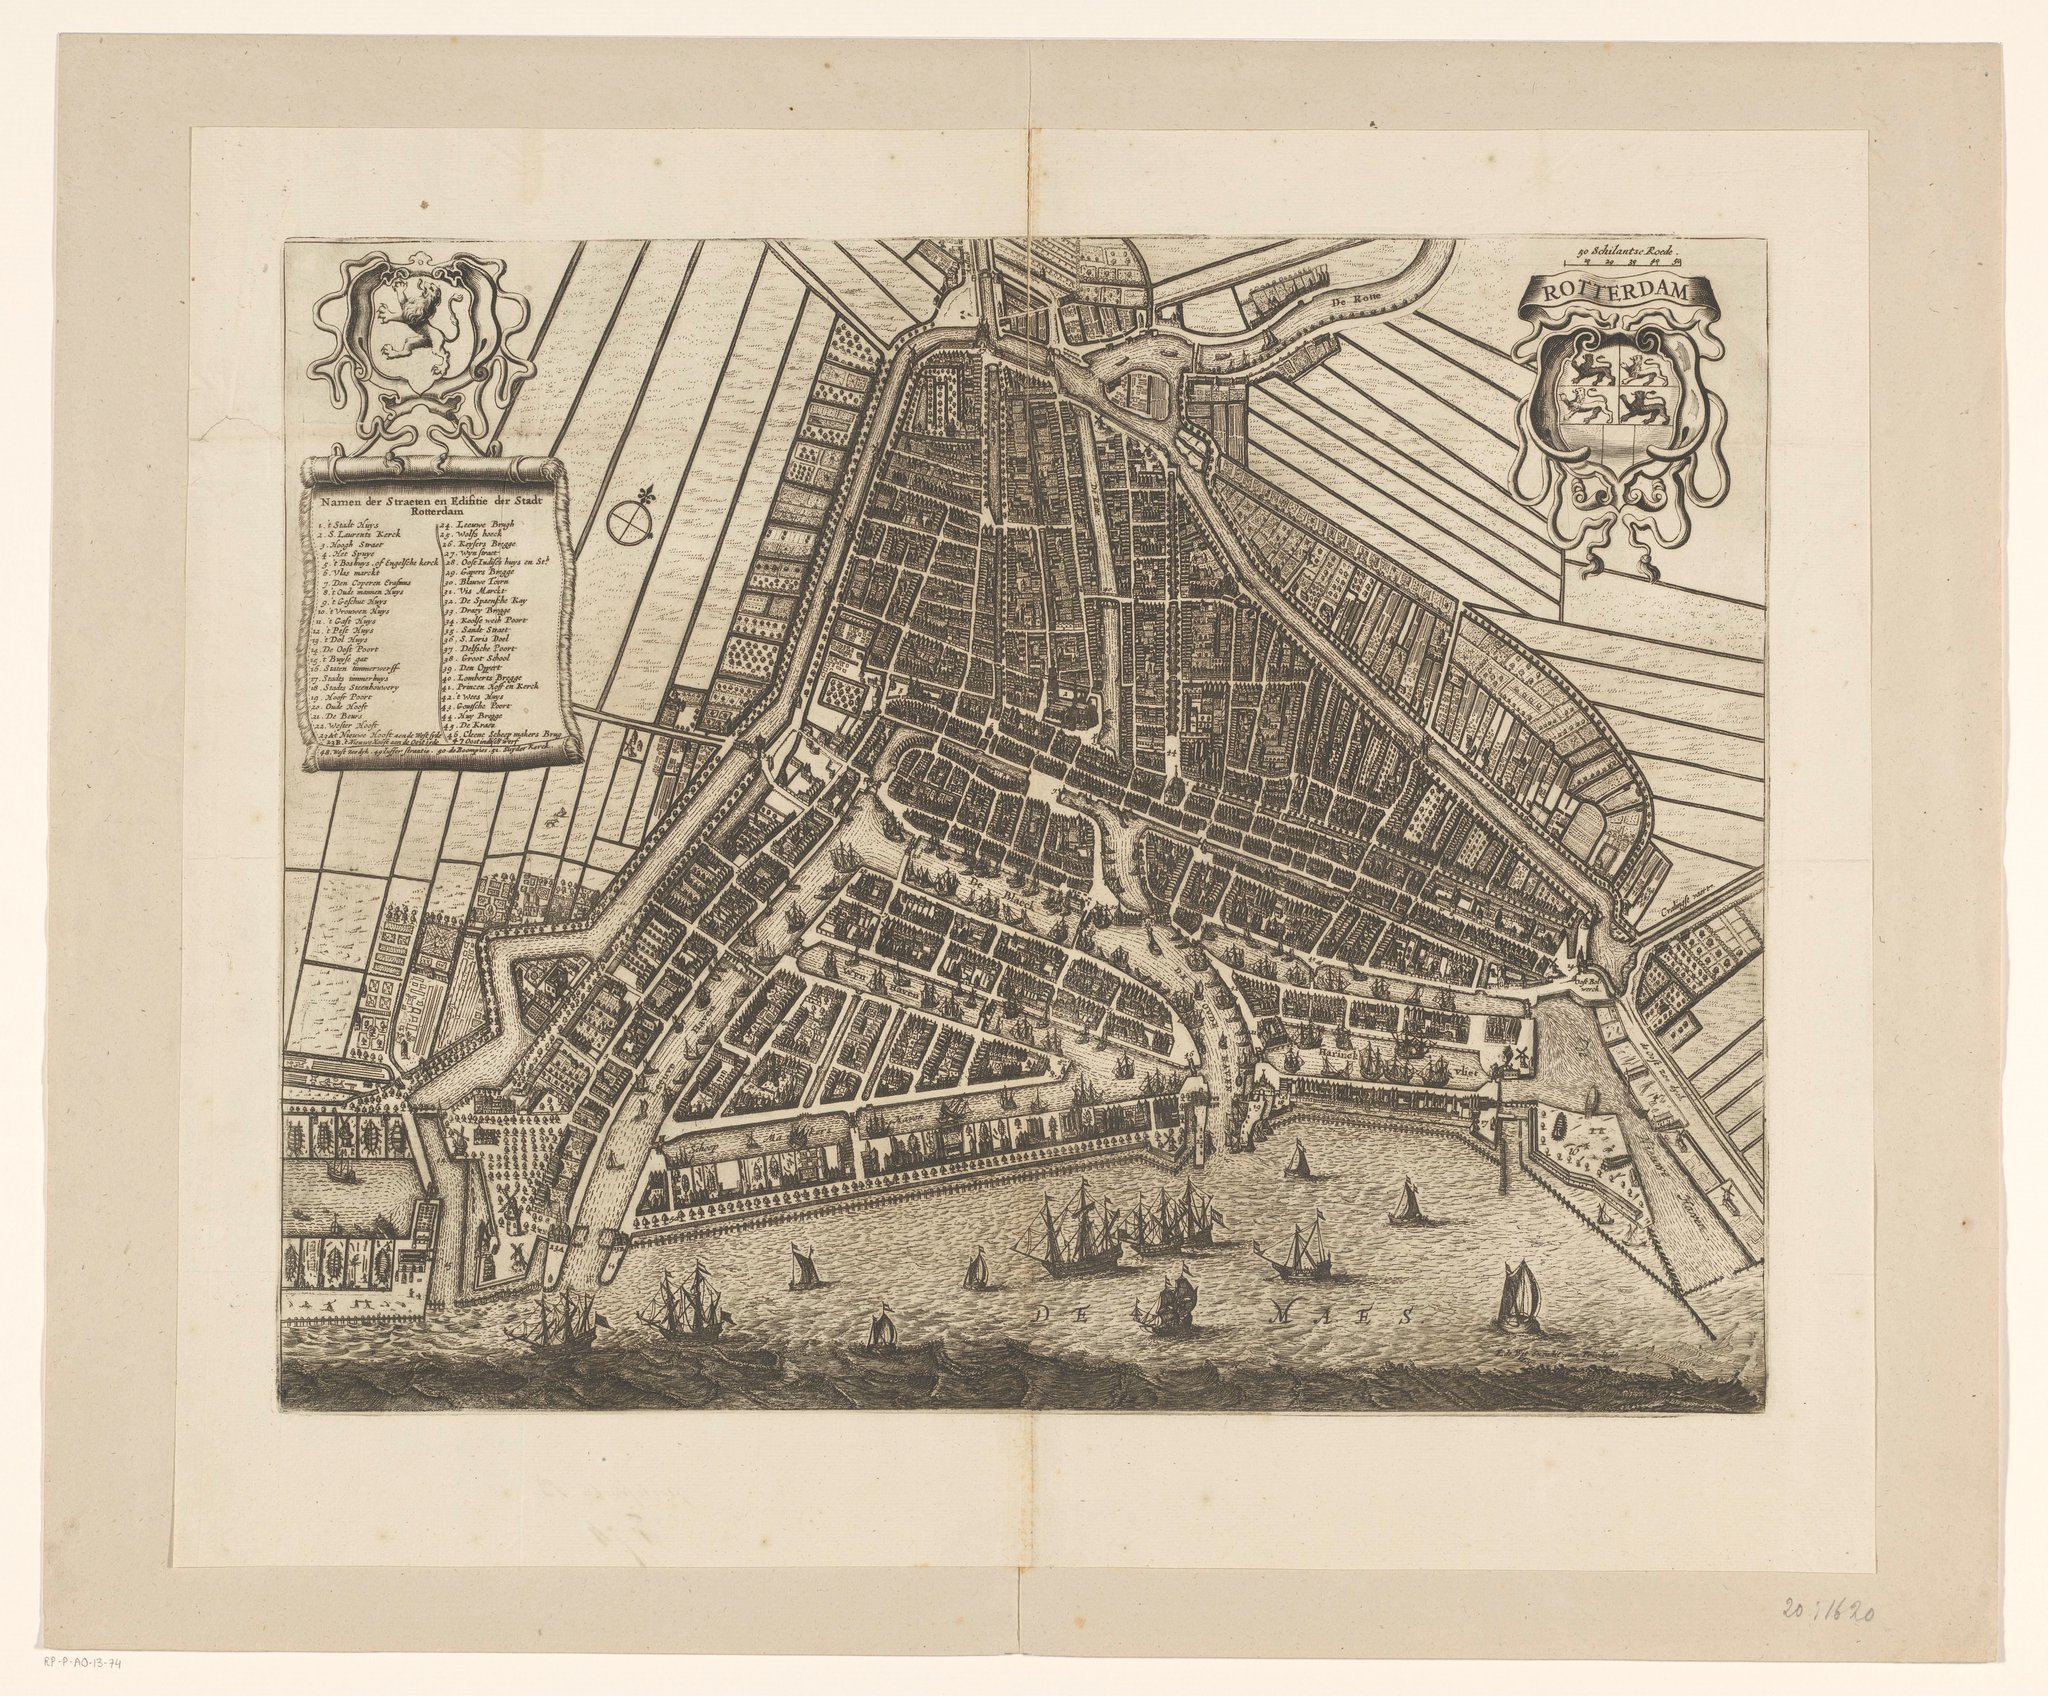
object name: area plan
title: Rotterdam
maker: Anonymous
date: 1657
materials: paper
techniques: engraving, etching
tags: coat of arms (as symbol of the state, etc.) (+ city; municipal), maps of cities, coat of arms (as symbol of the state, etc.) (+ province; provincial), rotterdam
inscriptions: collector's mark: Lugt 2233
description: Deze staat van prent ook gebruikt in: Theatrum ichnographicum omnium urbium et praecipuorum oppidorum Belgicarum XVII Provinciarum (…). Amsterdam: Frederik de Wit, ca. 1698-1704. En in: Theatrum ichnographicum omnium urbium et praecipuorum oppidorum Belgicarum XVII Provinciarum (…). Amsterdam: Frederik de Wit, ca. 1700-1710. En in: Aa, Pieter van der. La galerie agreable du monde (...). 66 delen. Leiden: Pieter van der Aa, 1728, dl. 18.